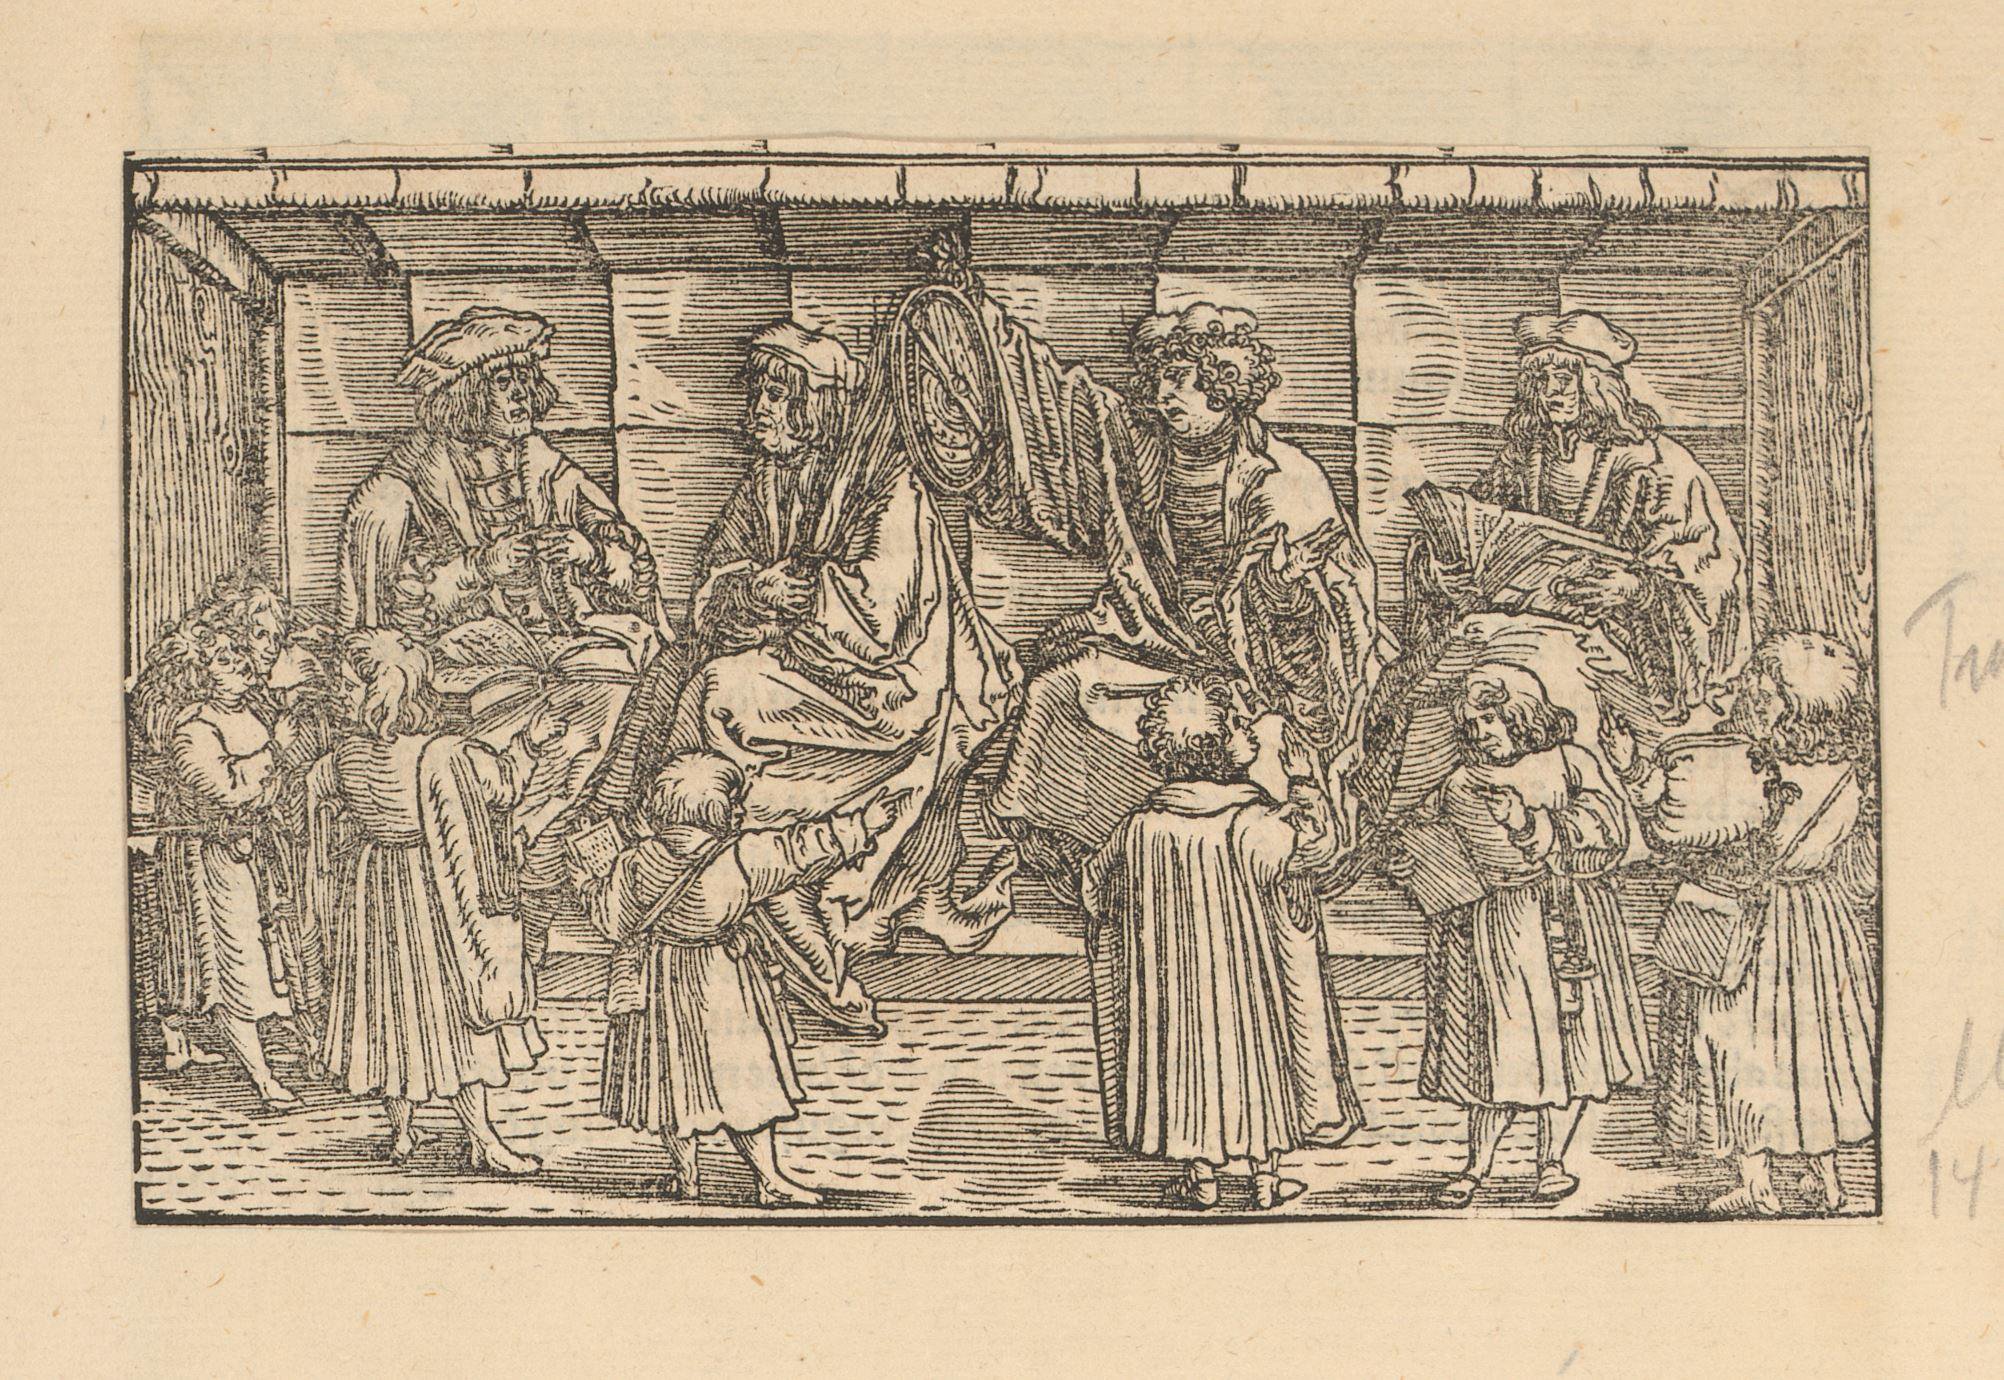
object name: book illustration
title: Vier leraren op een bank met kinderen daarvoor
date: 1514-1532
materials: paper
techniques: letterpress printing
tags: teacher and pupil, book, clock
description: Deze prent is gebruikt in: Petrarca, Francesco. Von der Artzney bayder Glück, des guten und widerwertigen: unnd weß sich ain yeder inn Gelück und Unglück halten sol (...). Augsburg: Heinrich Steiner, 1532. Deze uitgave is ook bekend onder de titel 'Trostspiegel in Glück und Unglück'. Deze prent is ook gebruikt in: Cicero, Marcus Tulius. Officia M.T.C. Ein Buch so Marcus Tullius Cicero der Römer zu seynem (...). [Vertaald uit het Latijn door] Johann von Schwarzenberg. Augsburg: Heinrich Steiner, 1531.